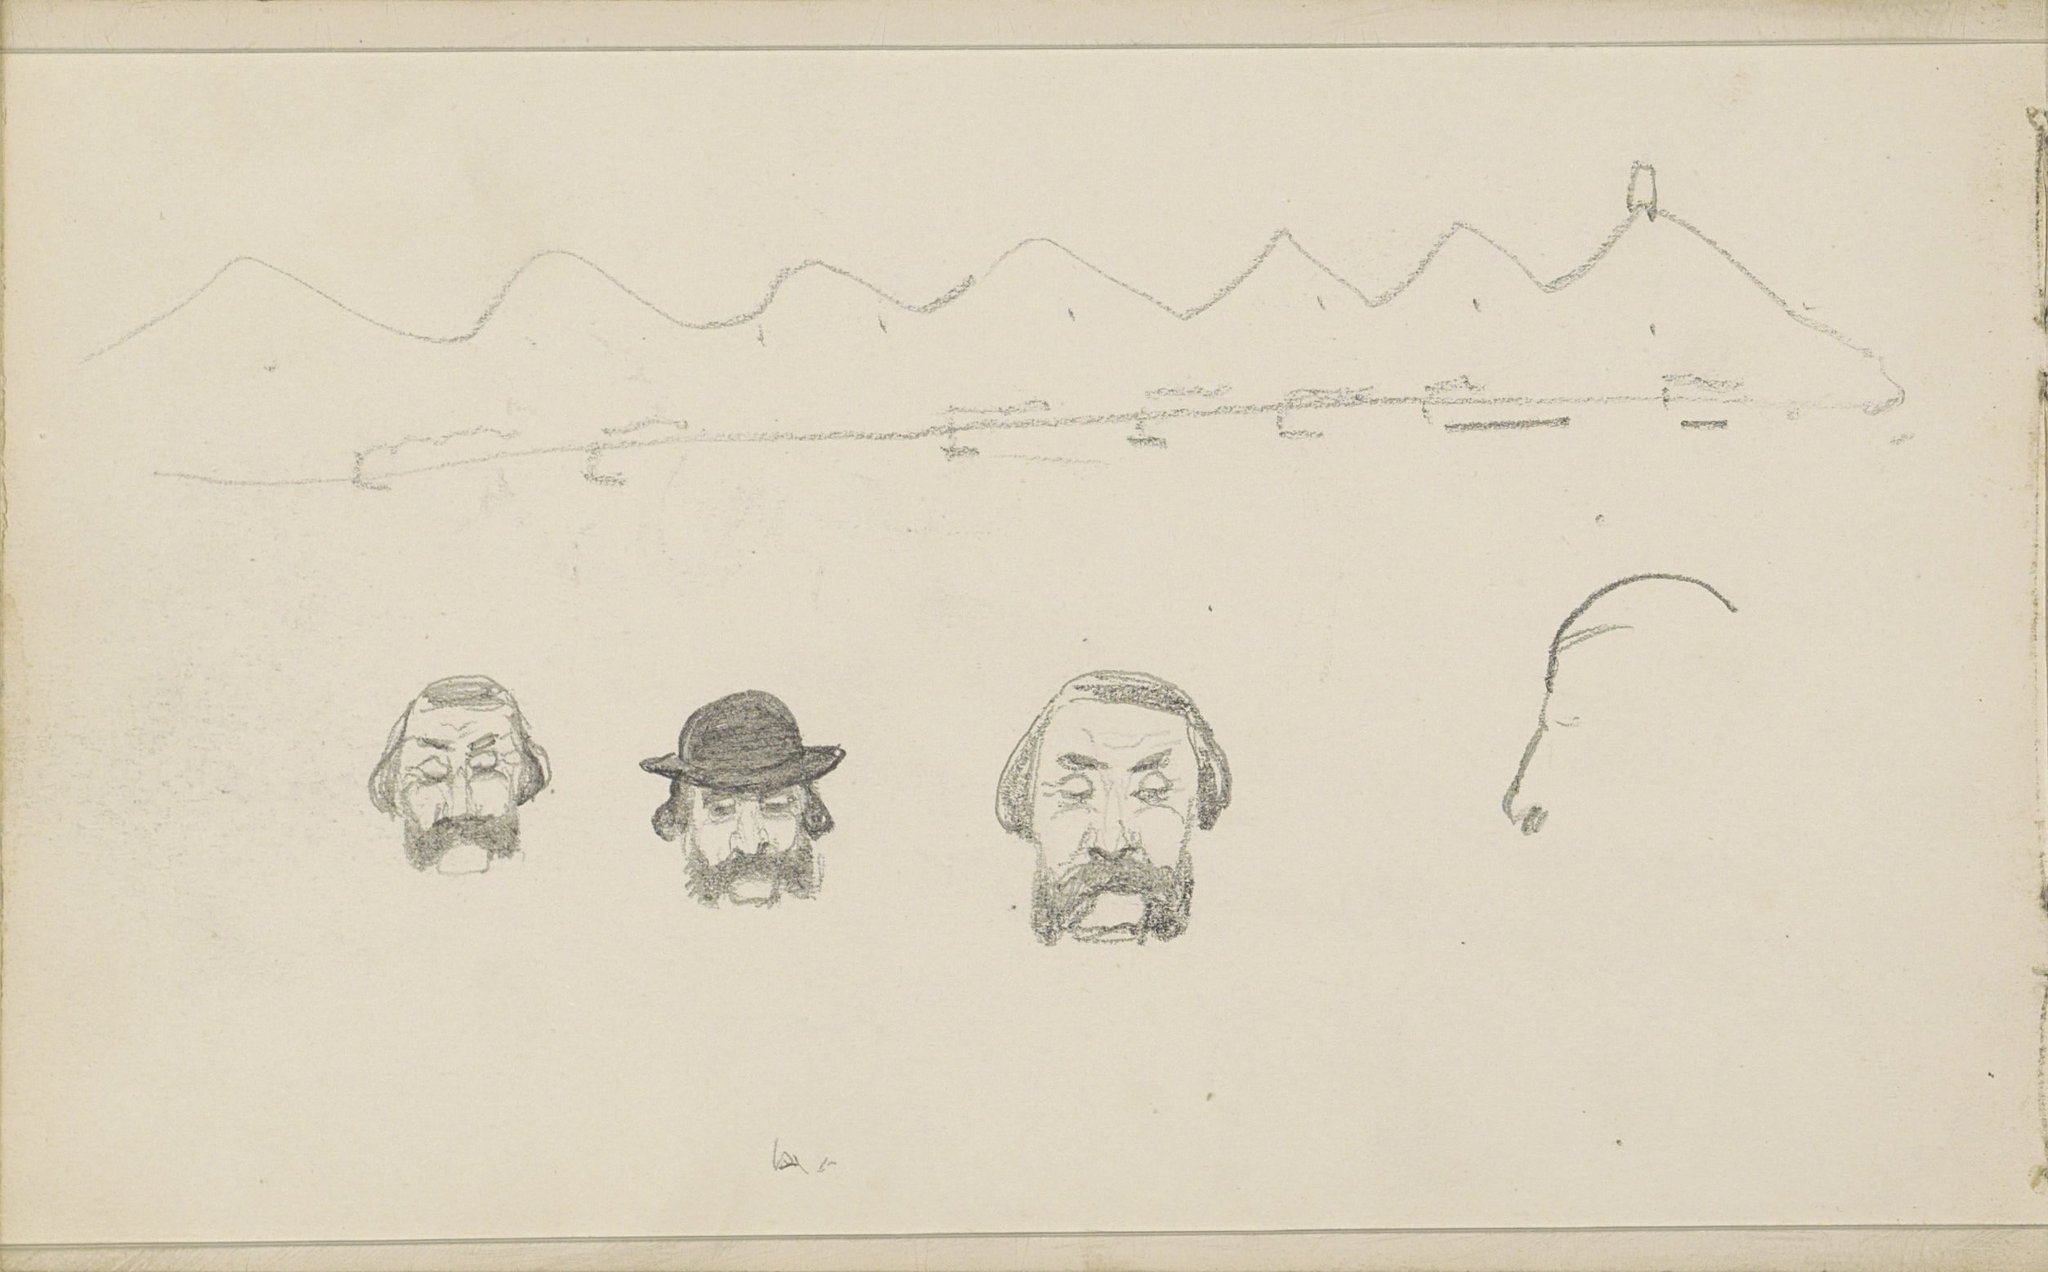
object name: sketchbook leaf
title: Koppen van een man met een snor en hoed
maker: anton mauve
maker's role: draughtsman, painter, print maker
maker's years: 1838-1888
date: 1848-1888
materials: paper, pencil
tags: head (human) (+ male human being (not to be used where -a- is prescribed))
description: Tevens een studie van stoomschepen op een rivier met op de achtergrond een berglandschap. Blad 2 verso uit een schetsboek met 42 bladen.